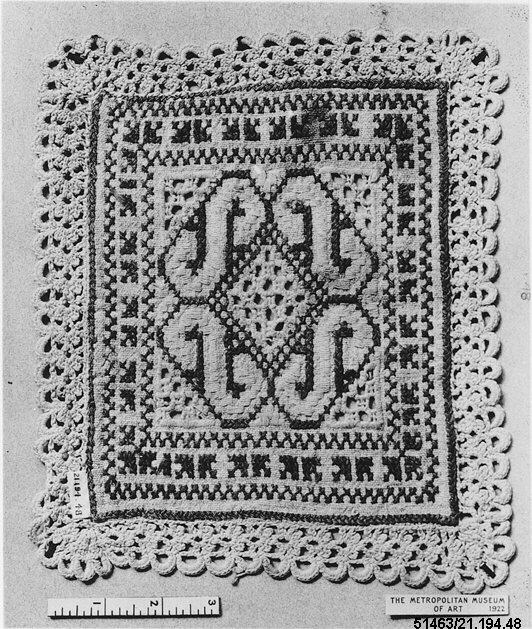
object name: mat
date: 1867-1900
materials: cotton, linen